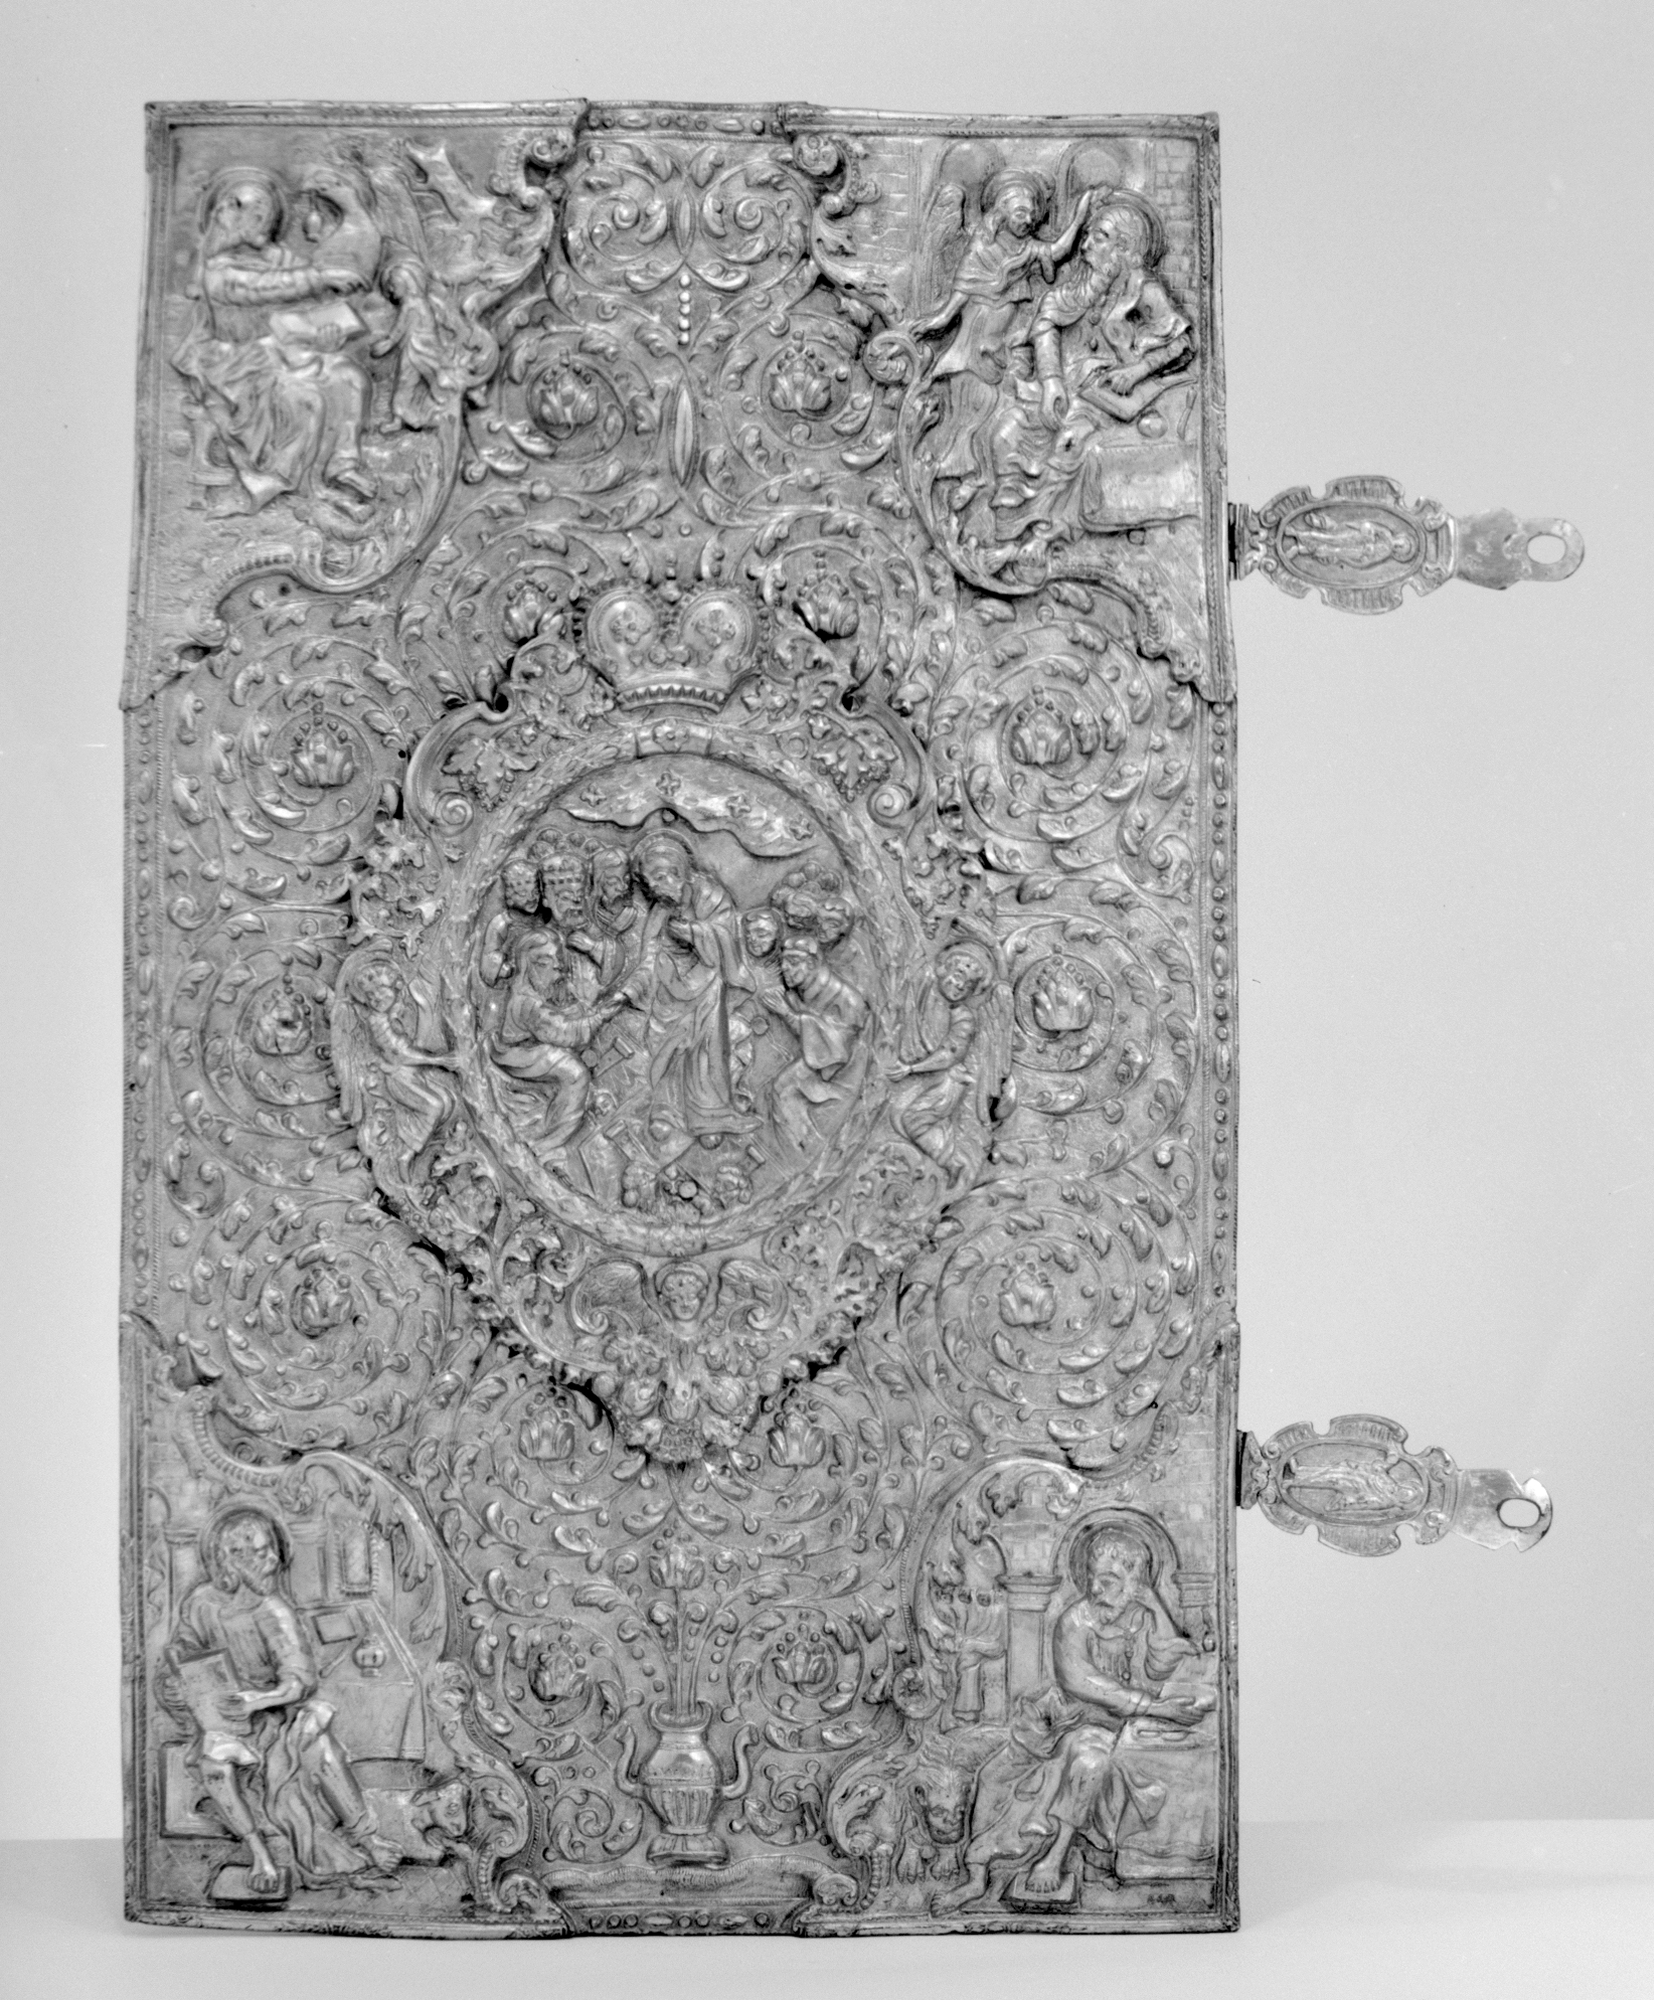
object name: book cover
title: Gospels cover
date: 1801-1900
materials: metal, silver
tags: men,women,reading